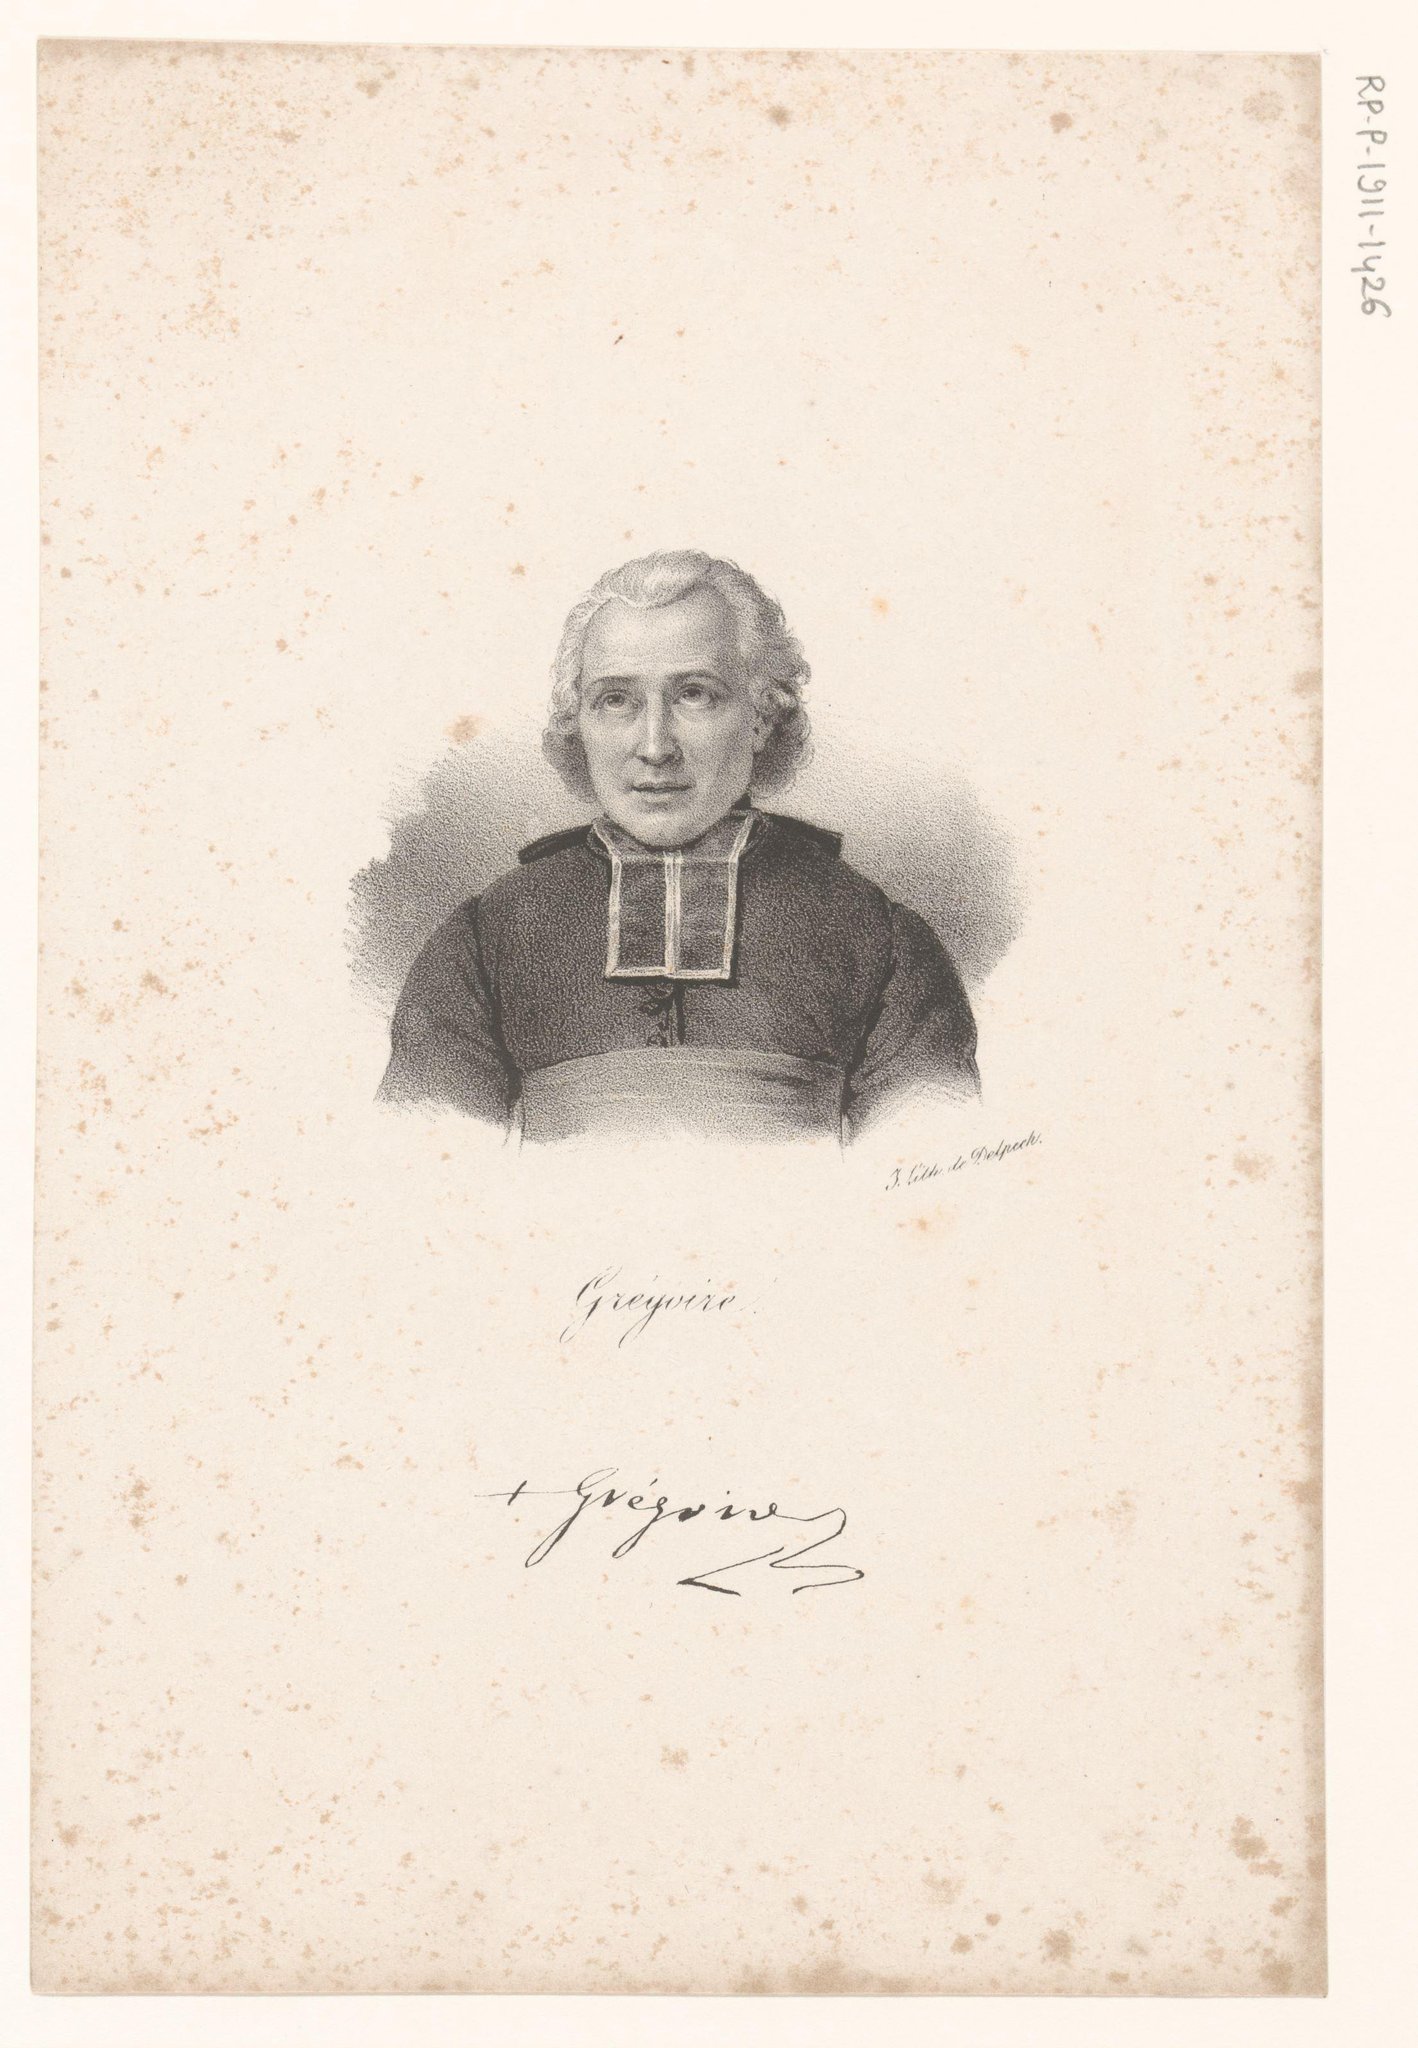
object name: print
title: Grégoire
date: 1818-1842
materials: paper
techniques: lithograph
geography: paris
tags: priest, historical persons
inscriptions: collector's mark: Lugt 2228a